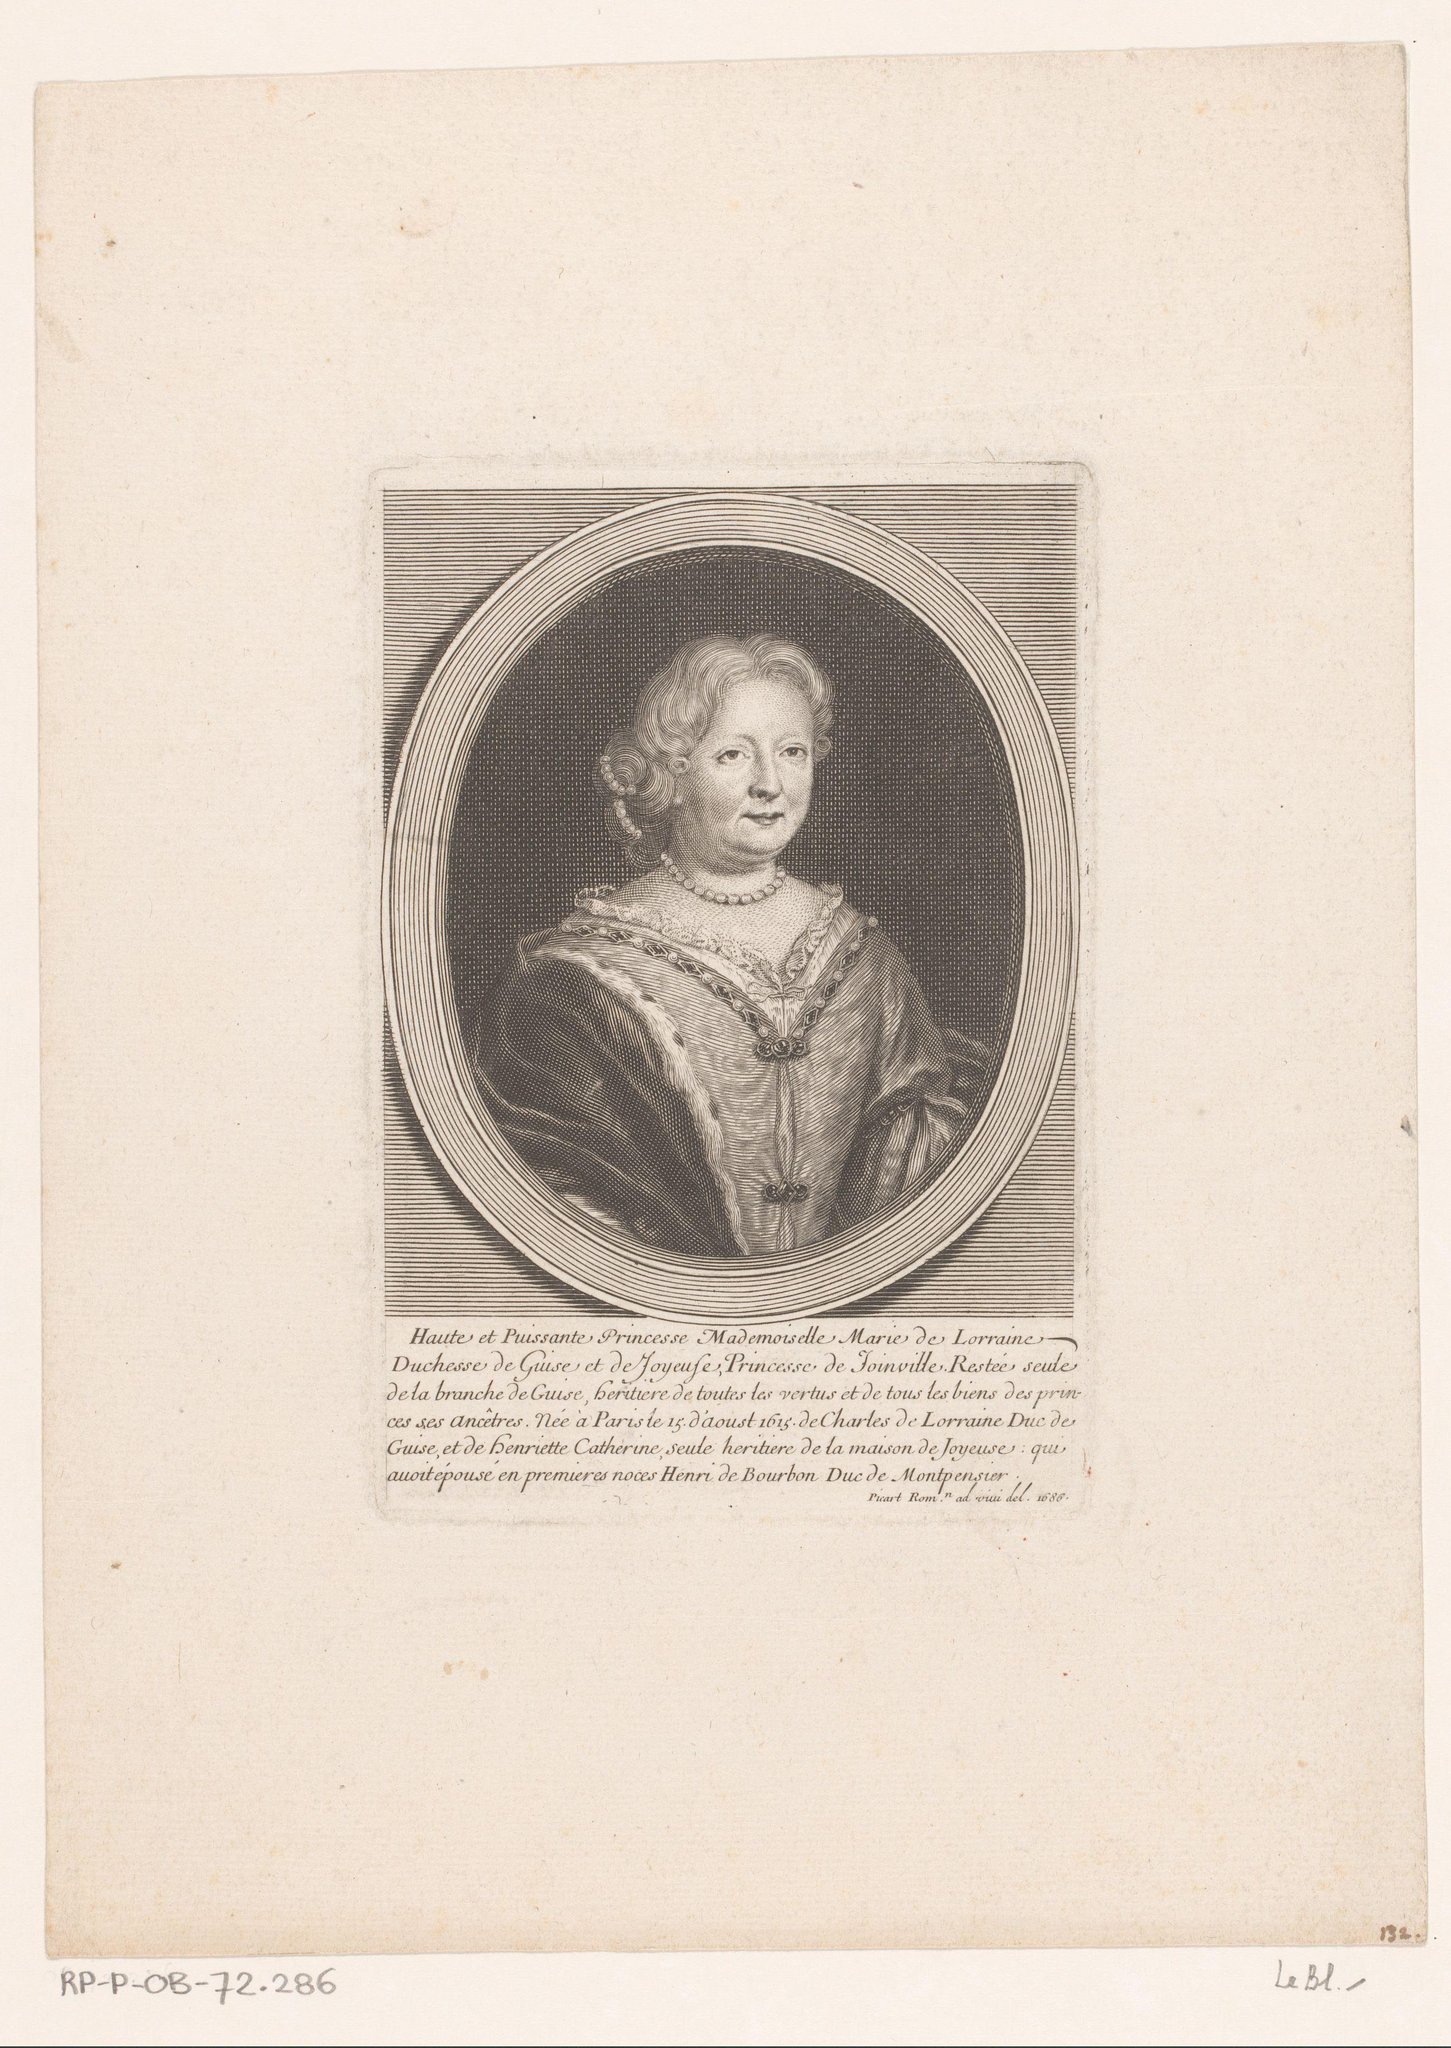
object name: print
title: Portret van Marie de Lorraine de Guise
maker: etienne picart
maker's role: draughtsman, print maker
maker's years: 1632-1721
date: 1686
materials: paper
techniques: engraving, etching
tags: paris, marie de lorraine de guise, historical persons, princess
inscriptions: collector's mark: Lugt 240